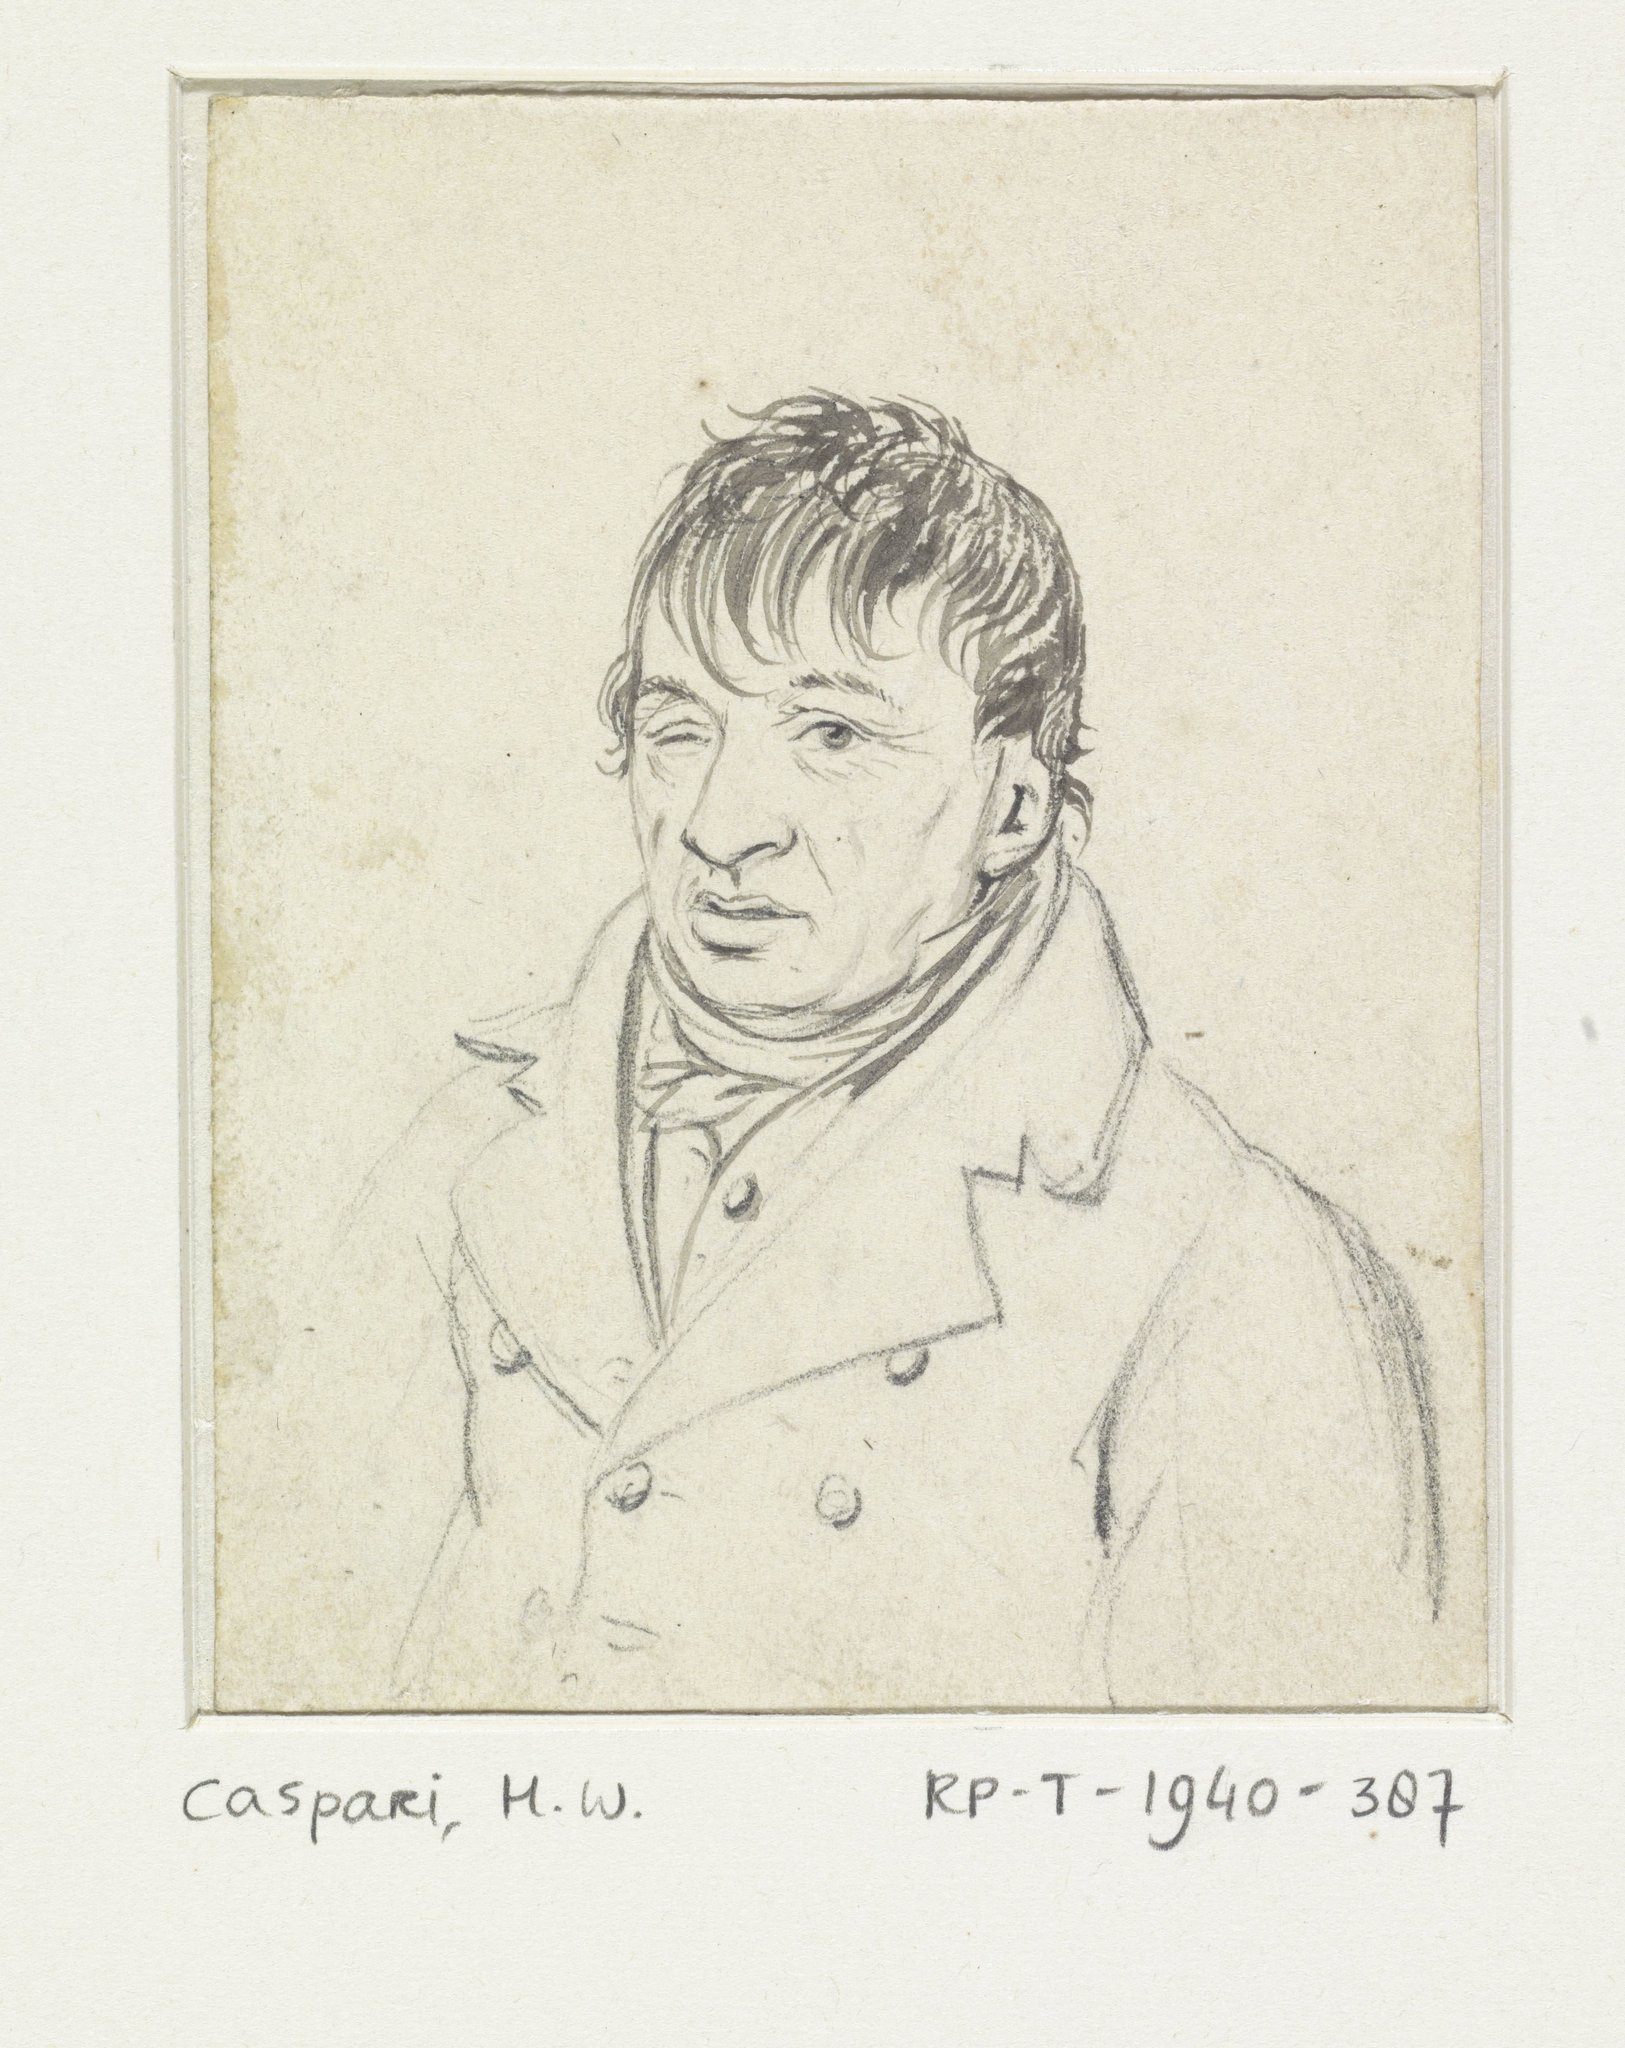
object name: drawing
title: Portret van A. Pira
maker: hendrik willem caspari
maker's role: draughtsman, print maker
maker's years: 1770-1829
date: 1780-1829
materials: paper, pencil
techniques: brush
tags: a. pira, historical persons, portrait, self-portrait of artist